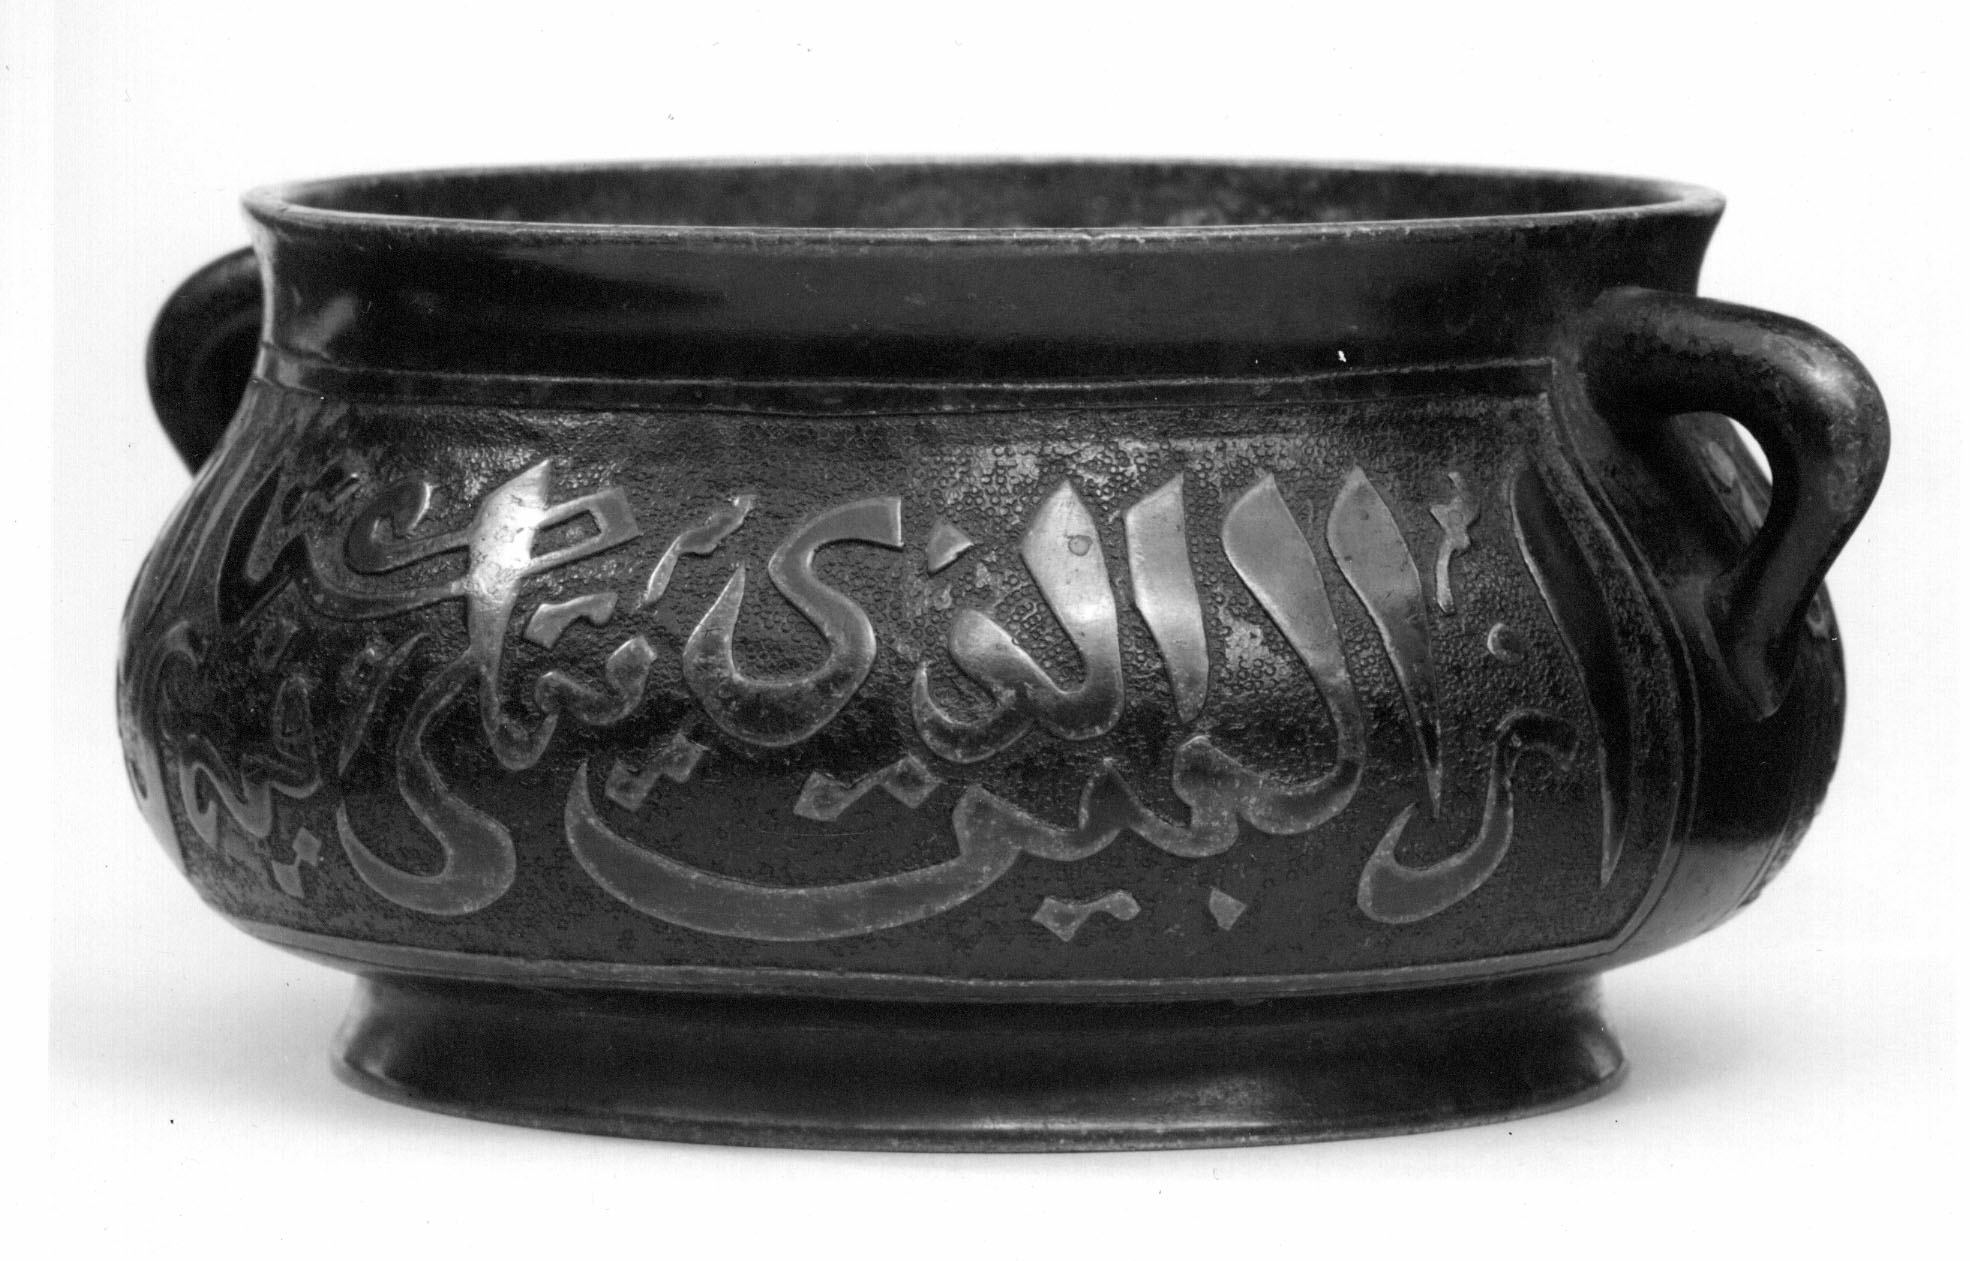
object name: incense burner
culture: chinese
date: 1506-1521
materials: bronze